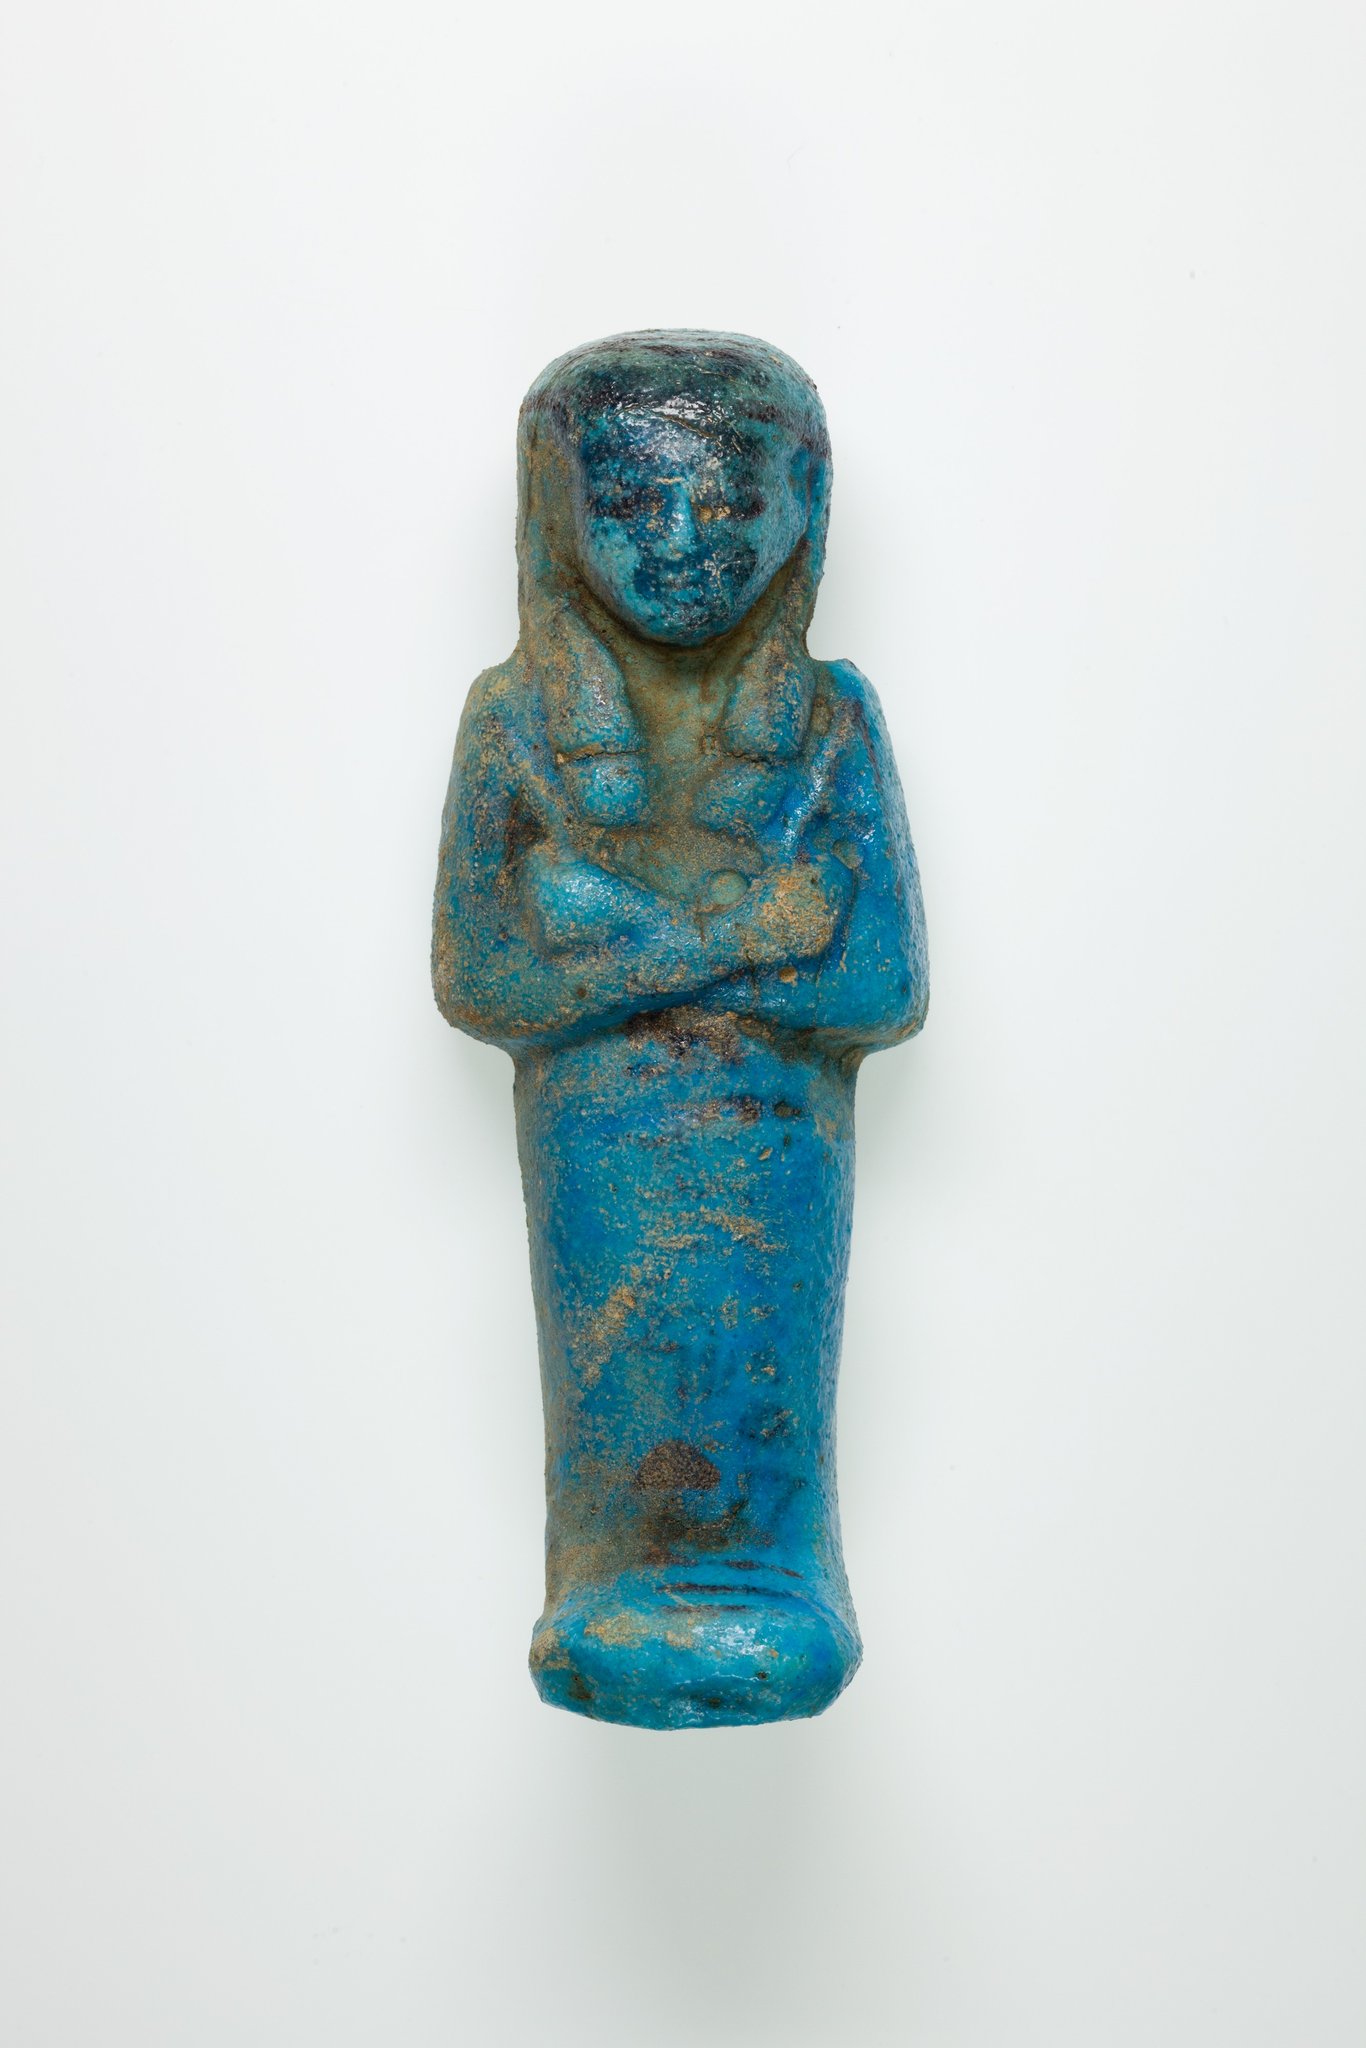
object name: worker shabti, henettawy c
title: Worker Shabti of Henettawy (C), Daughter of Isetemkheb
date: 990-970 BCE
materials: faience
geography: egypt